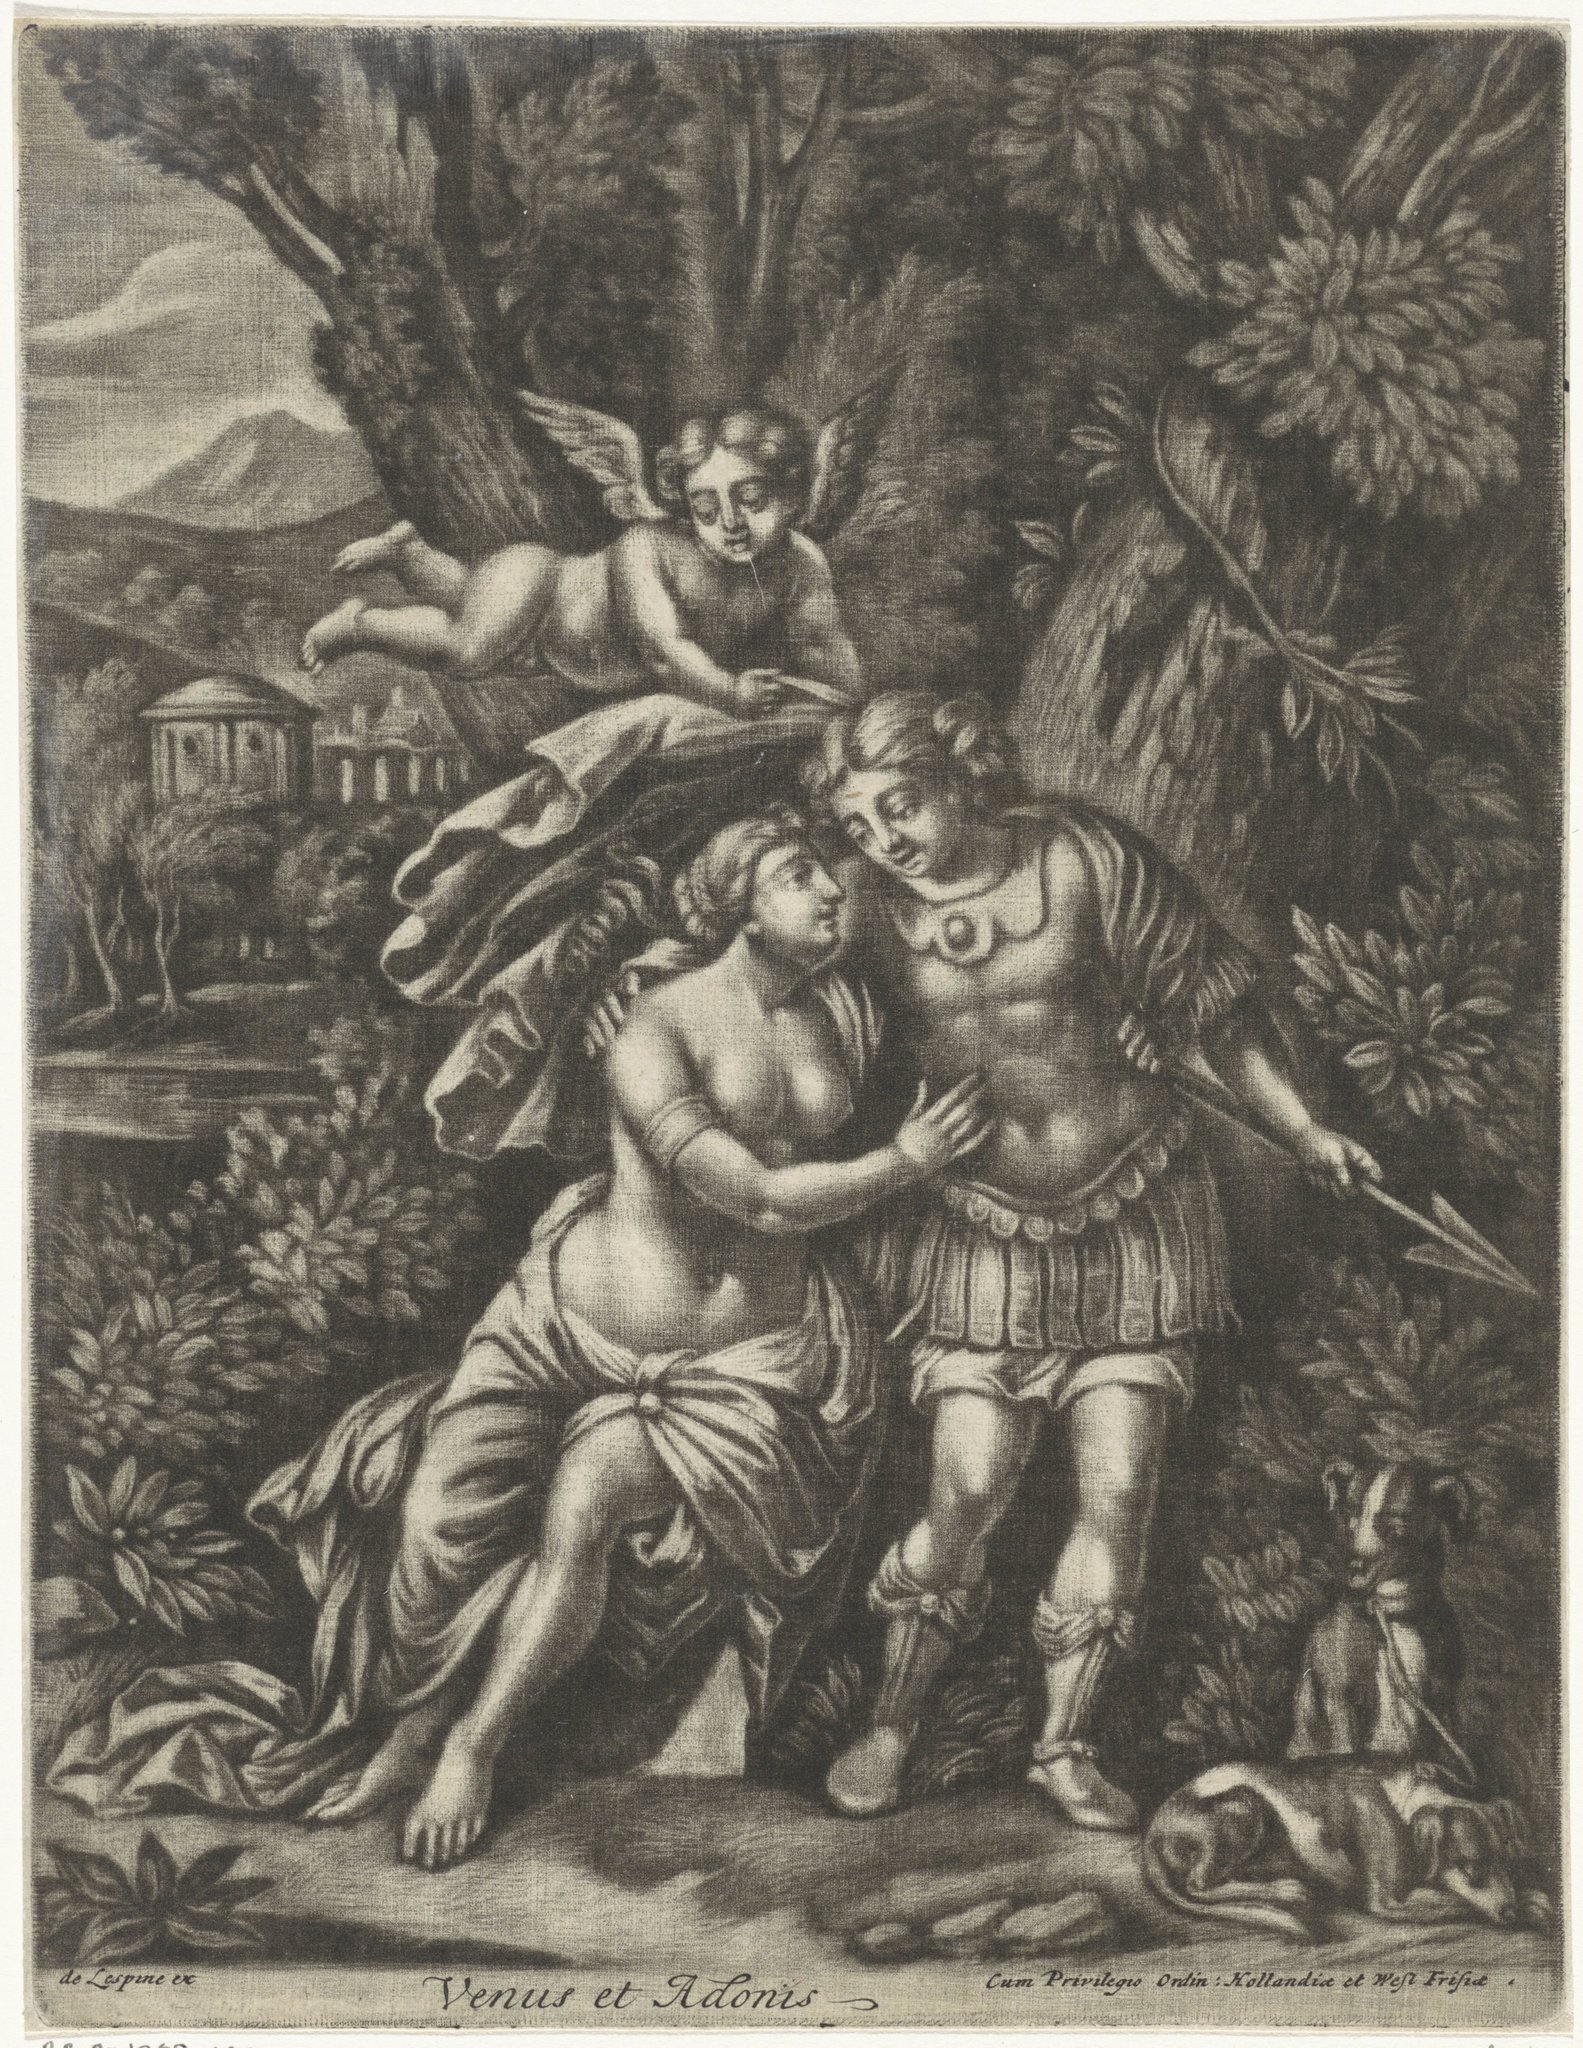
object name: print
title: Venus et Adonis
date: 1655-1700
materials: paper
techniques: mezzotint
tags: venus and adonis as lovers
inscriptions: collector's mark: Lugt 2228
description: Venus en Amor proberen Adonis te beletten om op jacht te gaan. Adonis gaat echter toch jagen; hij draagt een lans en naast hem lopen twee jachthonden.